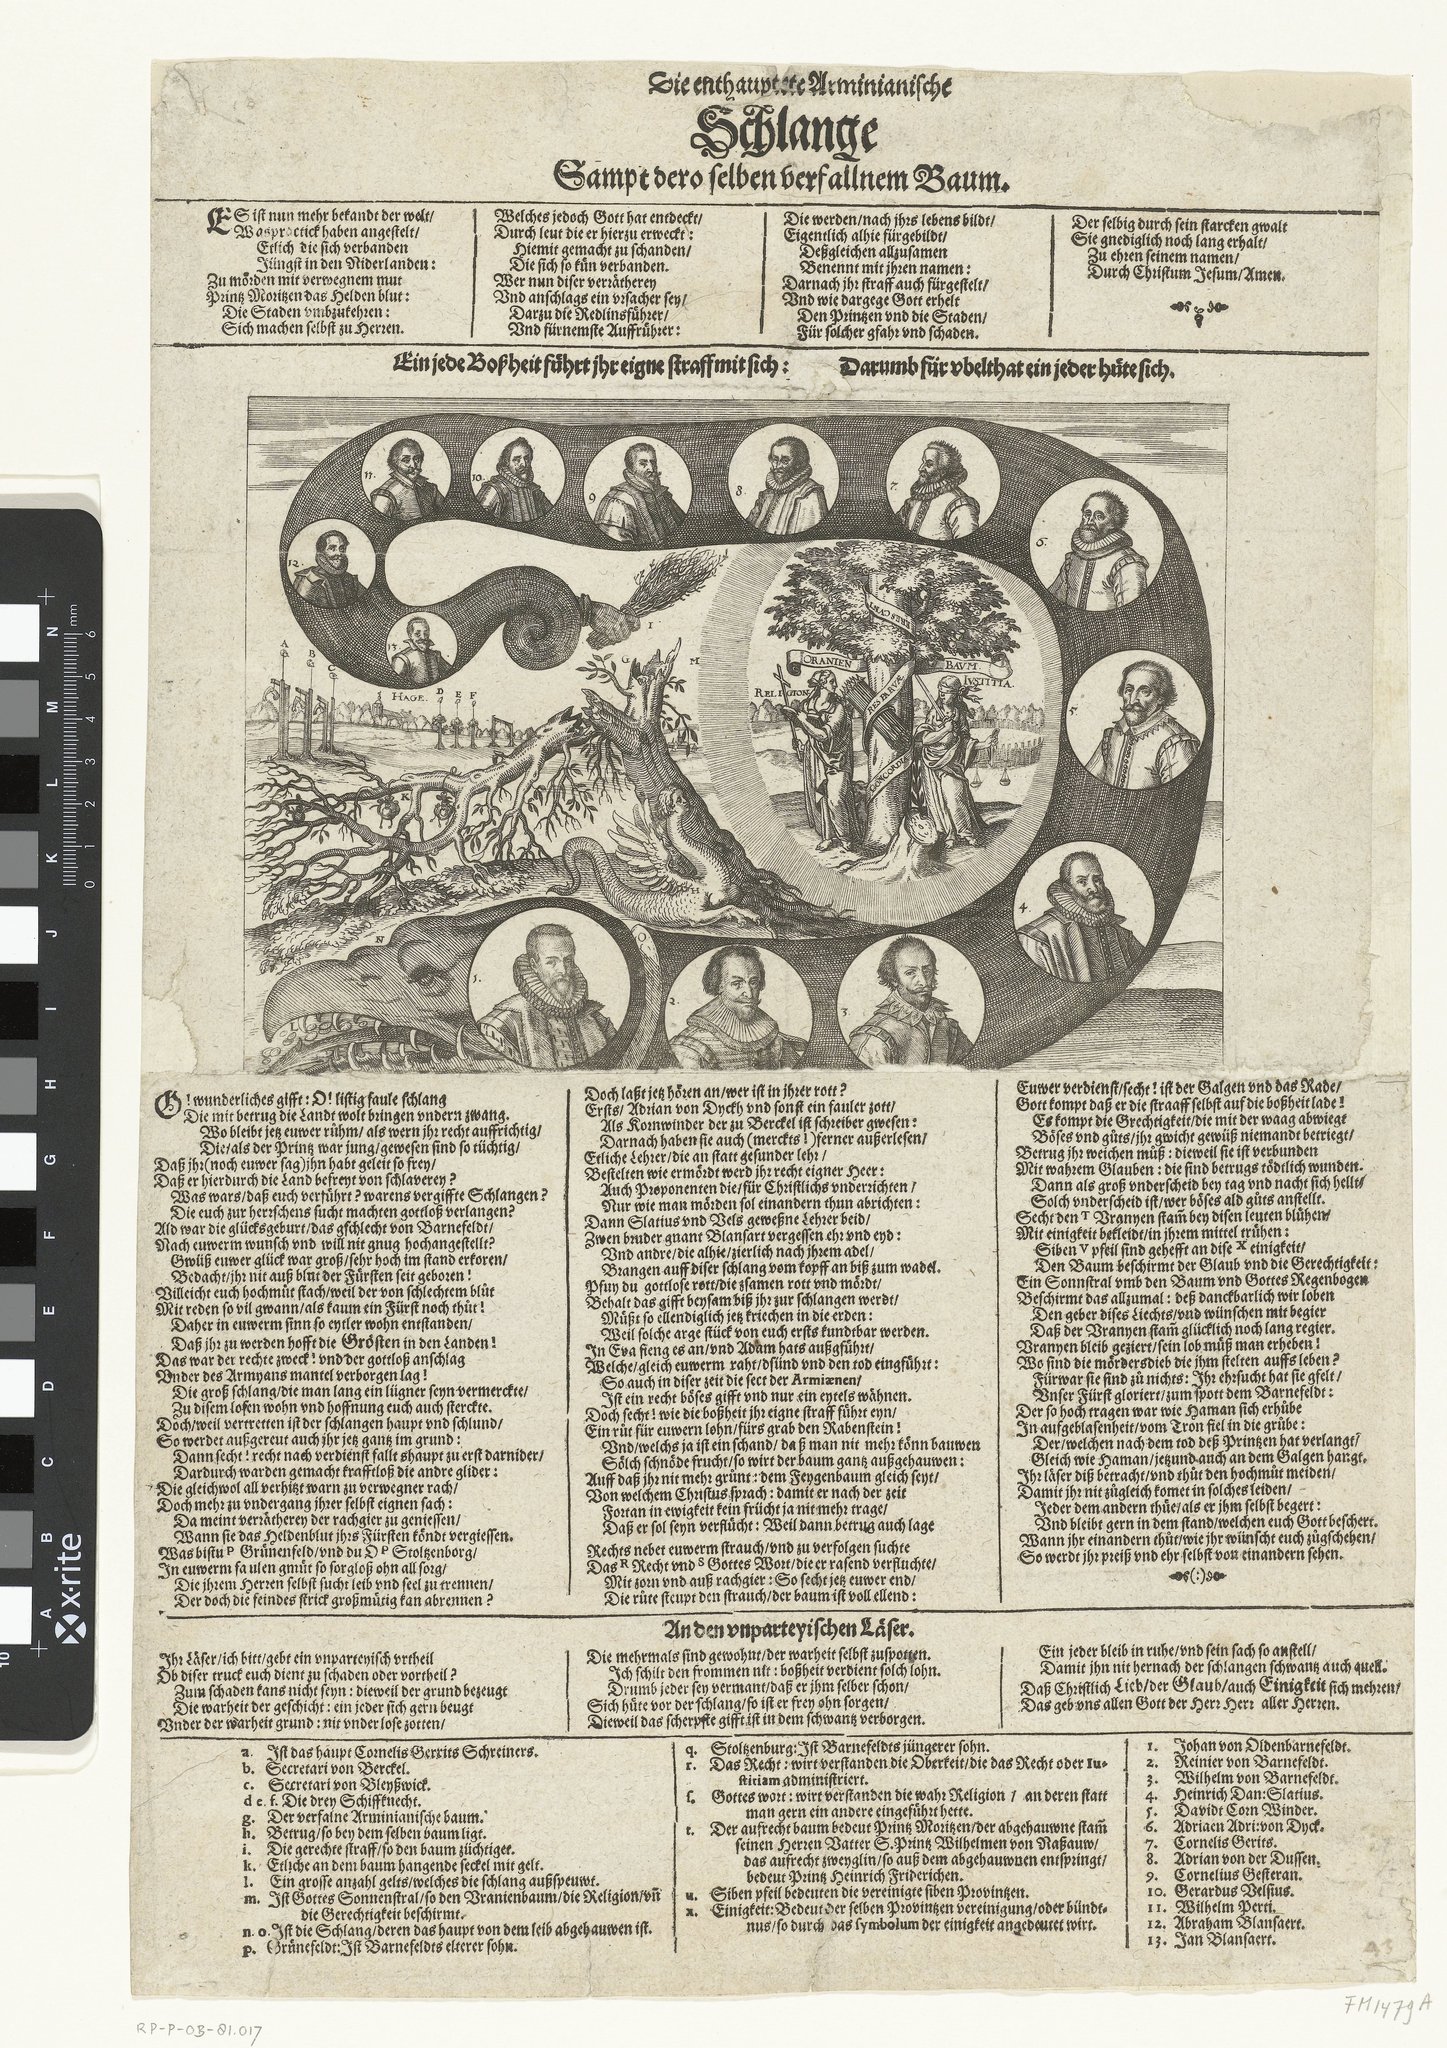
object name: print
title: Arminiaanse slang met de samenzweerders tegen Maurits, 1623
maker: Anonymous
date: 1623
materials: paper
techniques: etching, letterpress printing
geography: germany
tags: johan van oldenbarnevelt, maurice (prince of orange), brussels, bruges, assendelft, hoorn (north holland)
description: De Arminiaanse slang met de portretten van Johan van Oldenbarnevelt en de in 1623 gearresteerde samenzweerders tegen Maurits. In het midden de gebroken Arminiaanse boom en de bloeiende Oranjeboom beschermd door de personificaties van Religie en Rechtvaardigheid en het stralende licht Gods. In de staart van de slang een roede. Boven en onder de voorstelling teksten en de legenda's ax en 1-13 in het Duits.